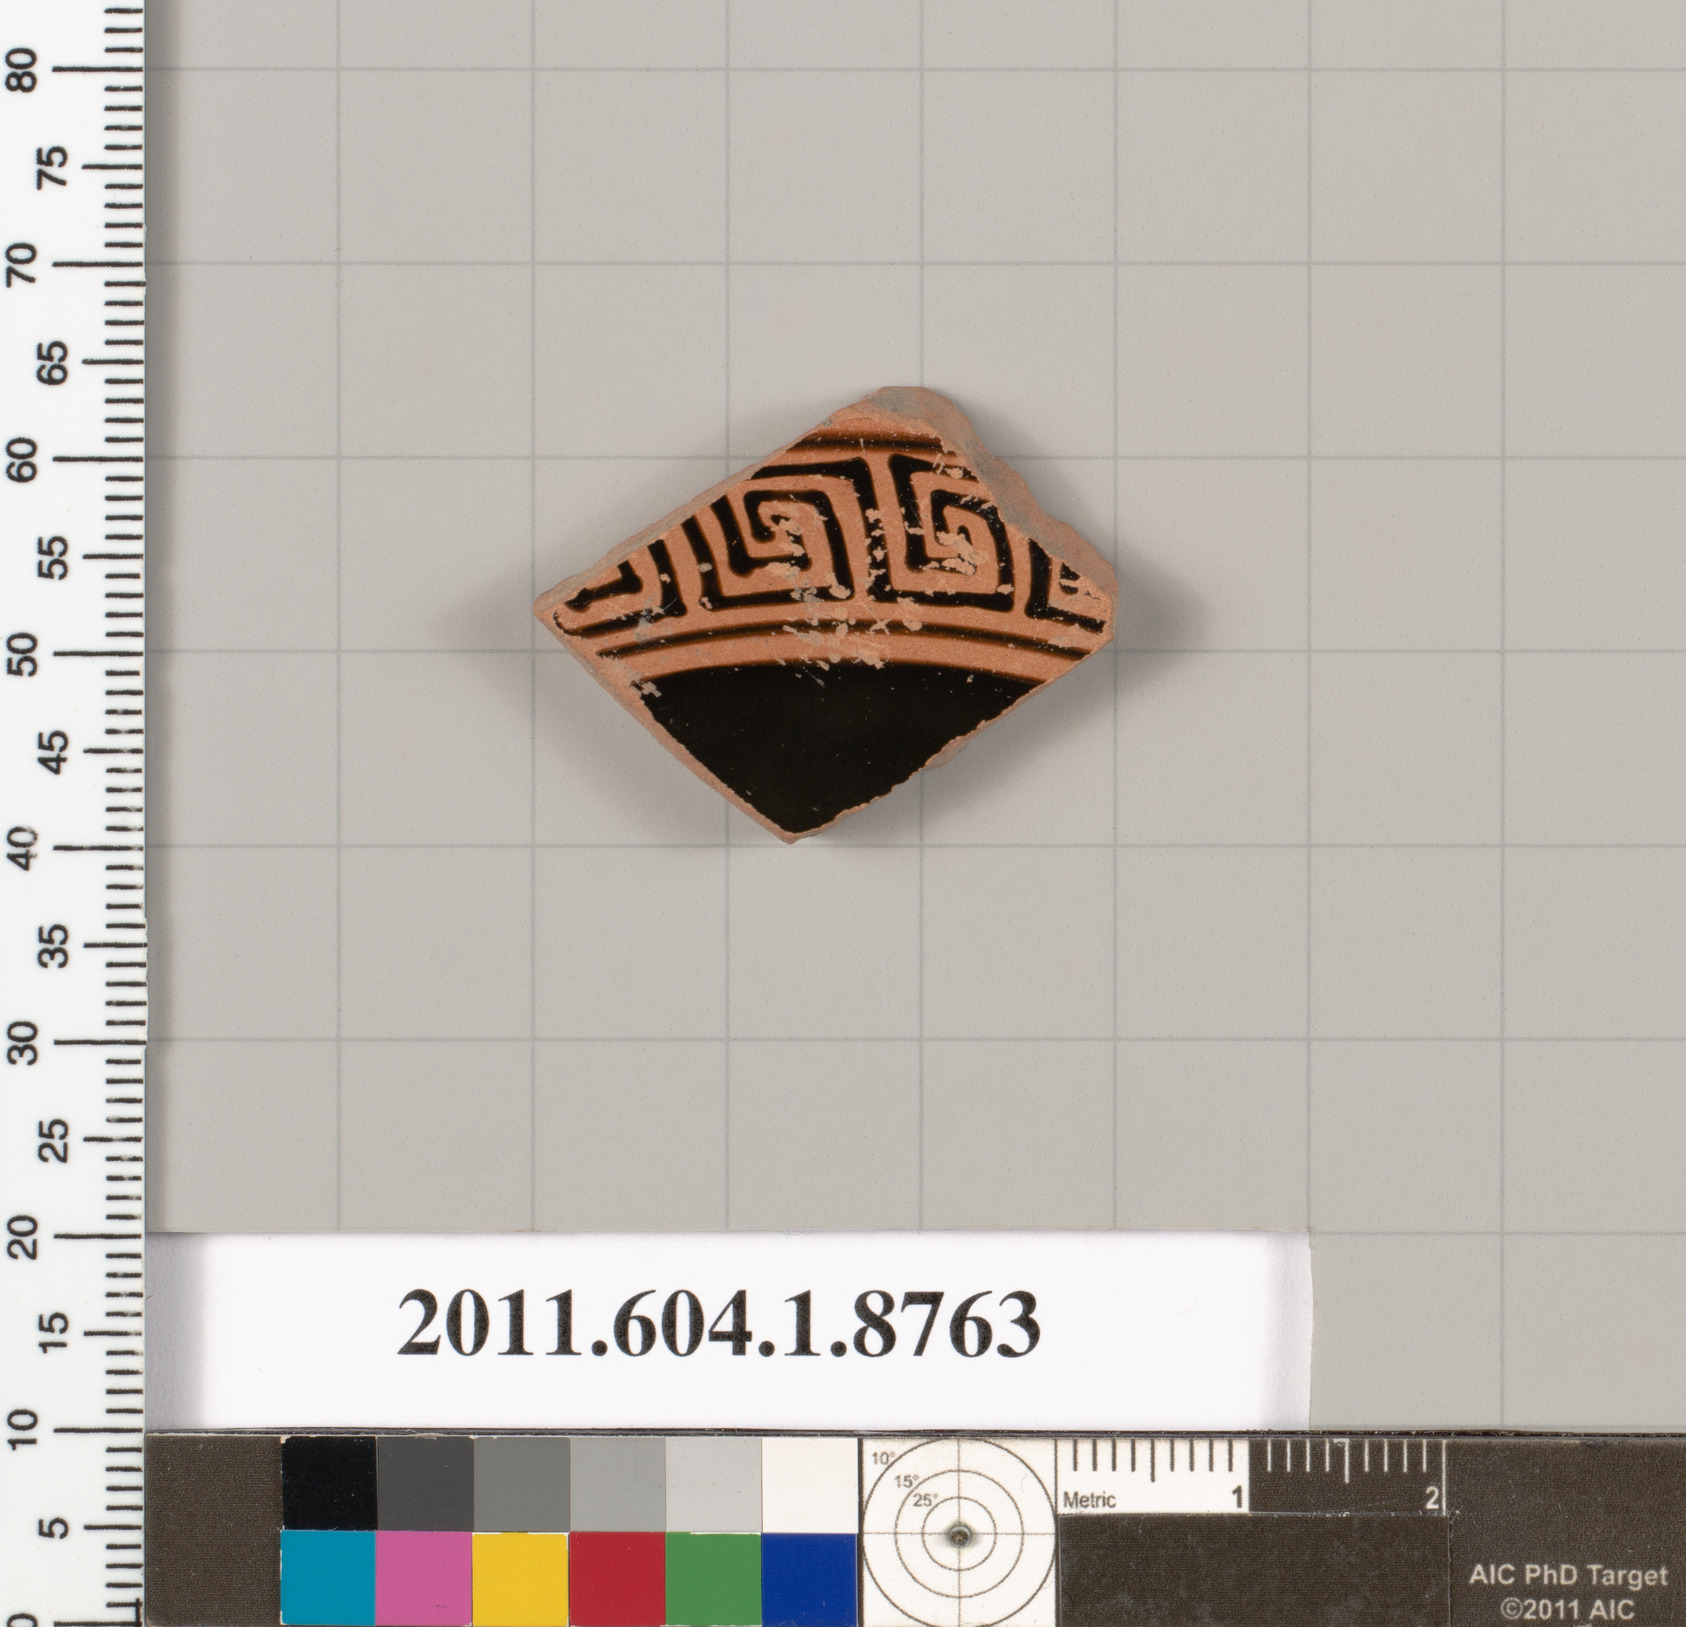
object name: kylix fragment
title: Terracotta fragment of a kylix (drinking cup)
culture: greek, attic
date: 500-480 BCE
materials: terracotta